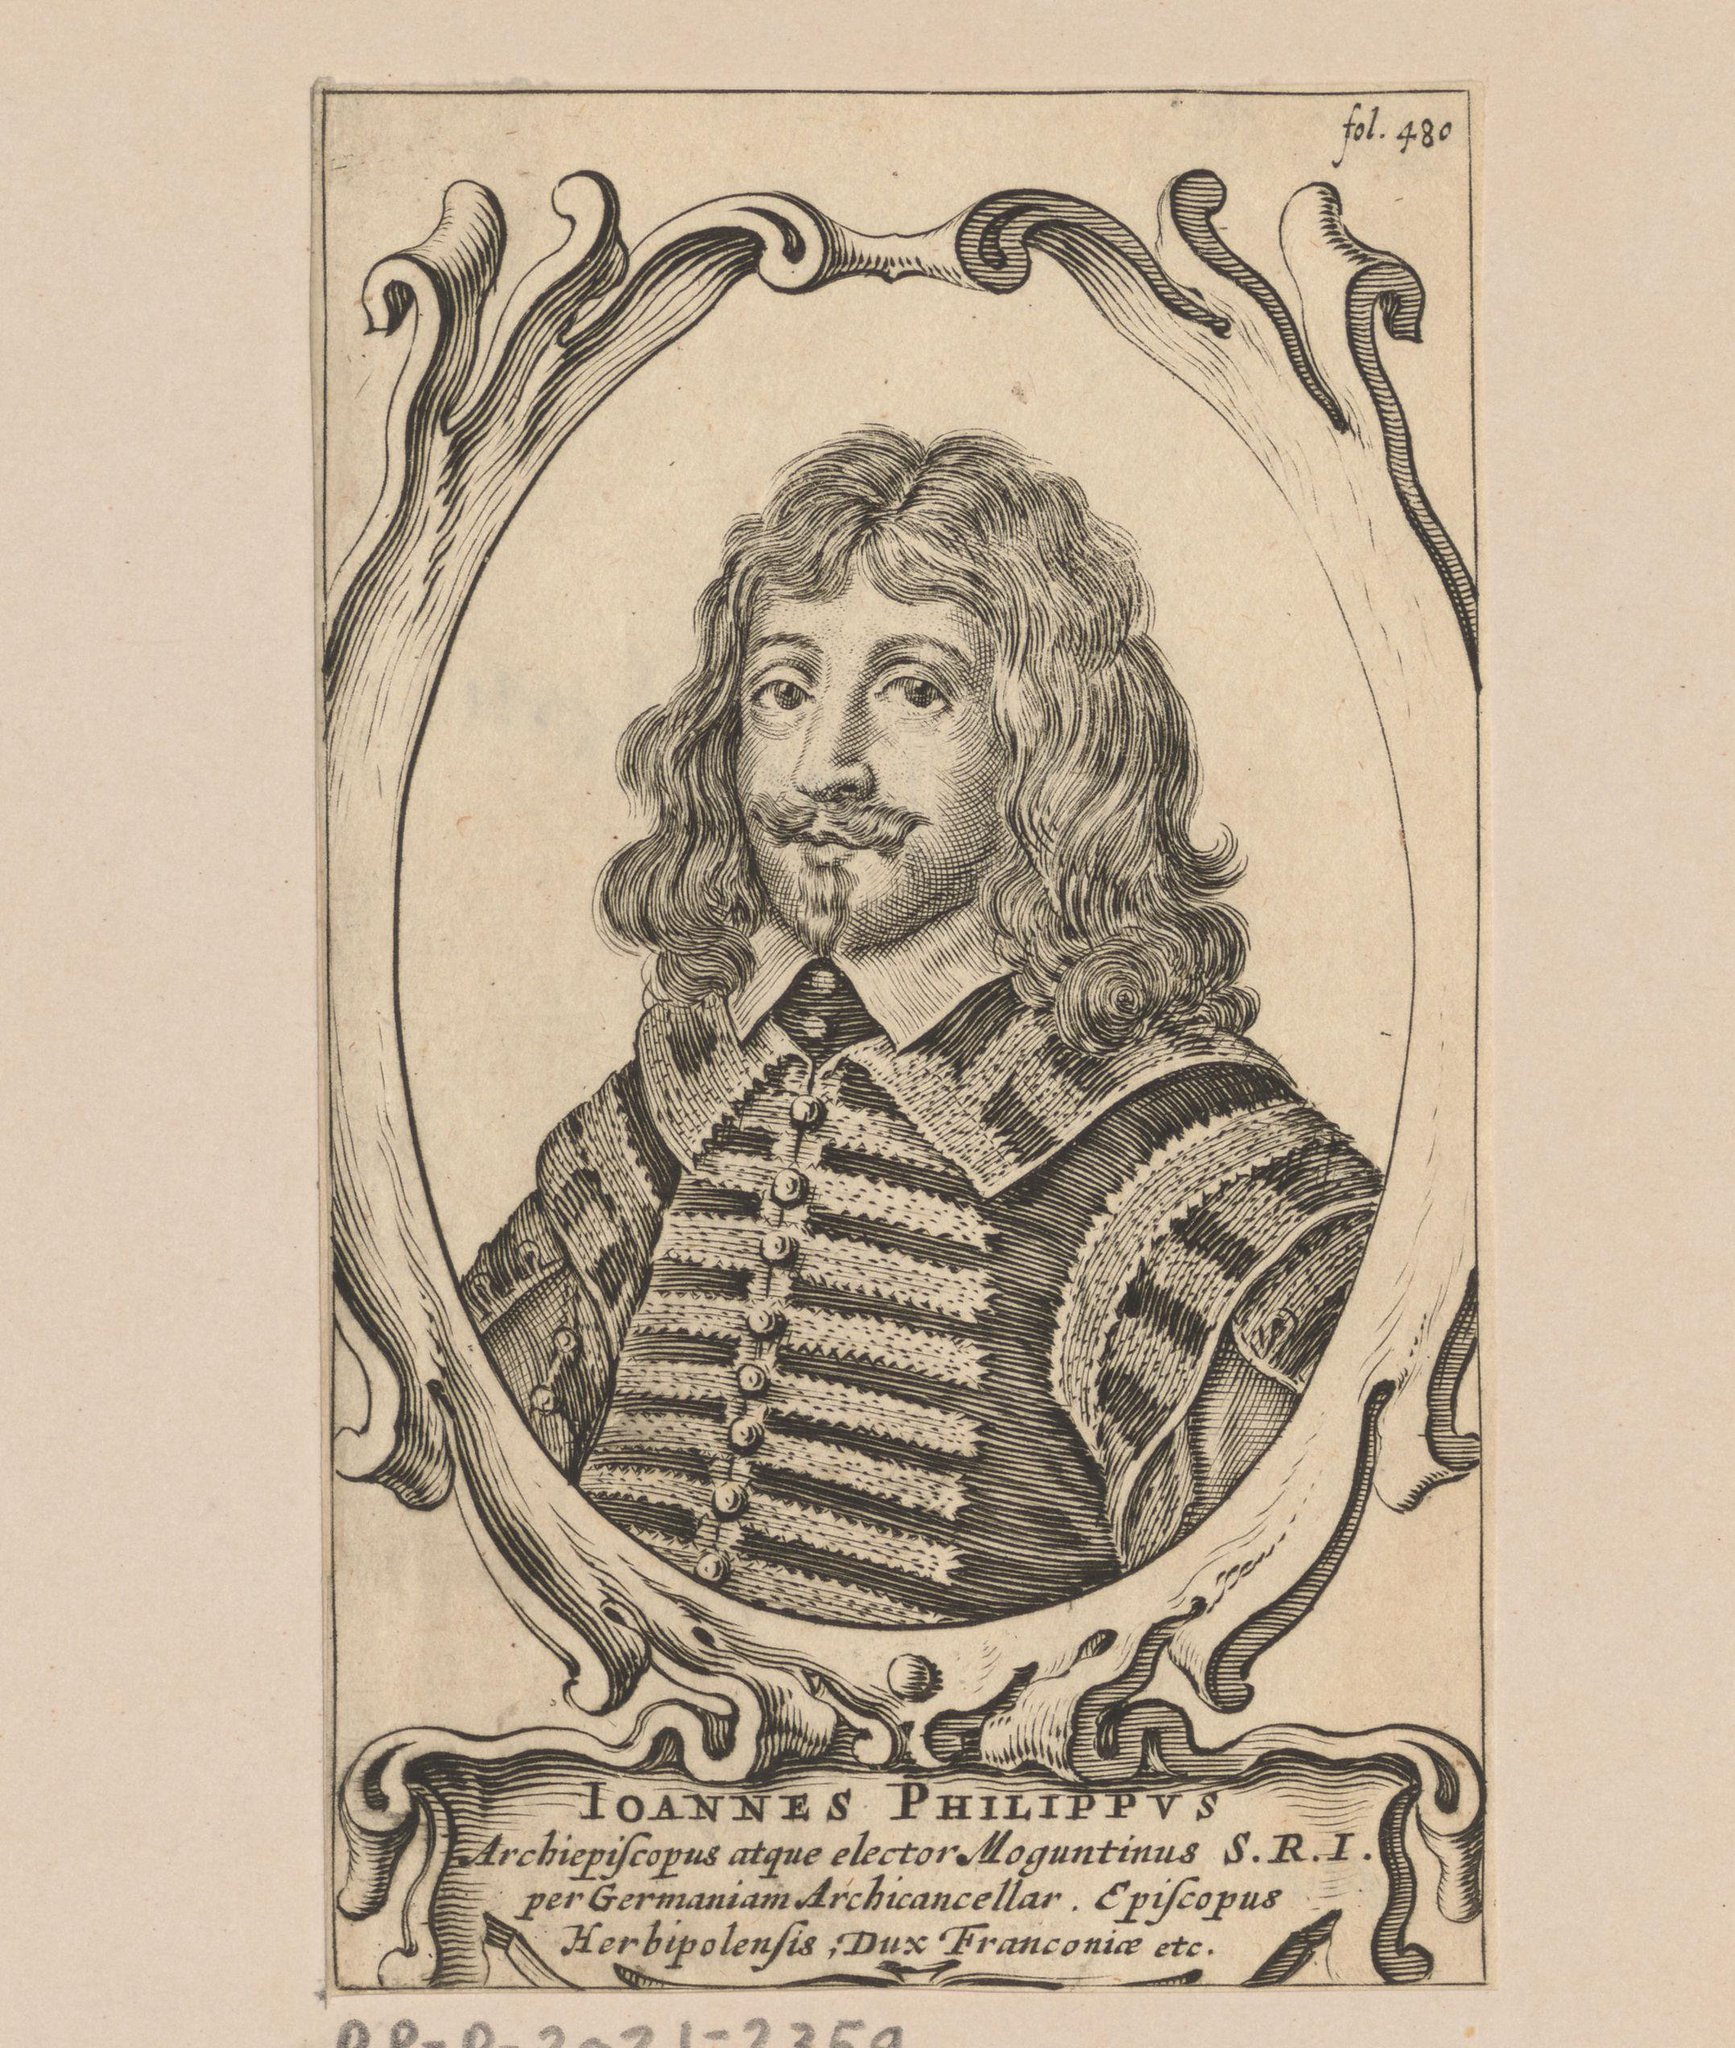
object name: print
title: Portret van Johann Philipp von Schönborn, aartsbisschop van Mainz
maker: Anonymous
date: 1656-1666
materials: paper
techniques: engraving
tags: archbishop, bishop, etc. (roman catholic), historical persons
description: Prent mogelijk uit: Brachelius, Johannes Adolphus. Historia nostri temporis, dat is geschiedenis onses tijts (…). Rotterdam: Andries van Hoogenhuysen, 1656. Of uit latere publicaties (1659 en 1666).